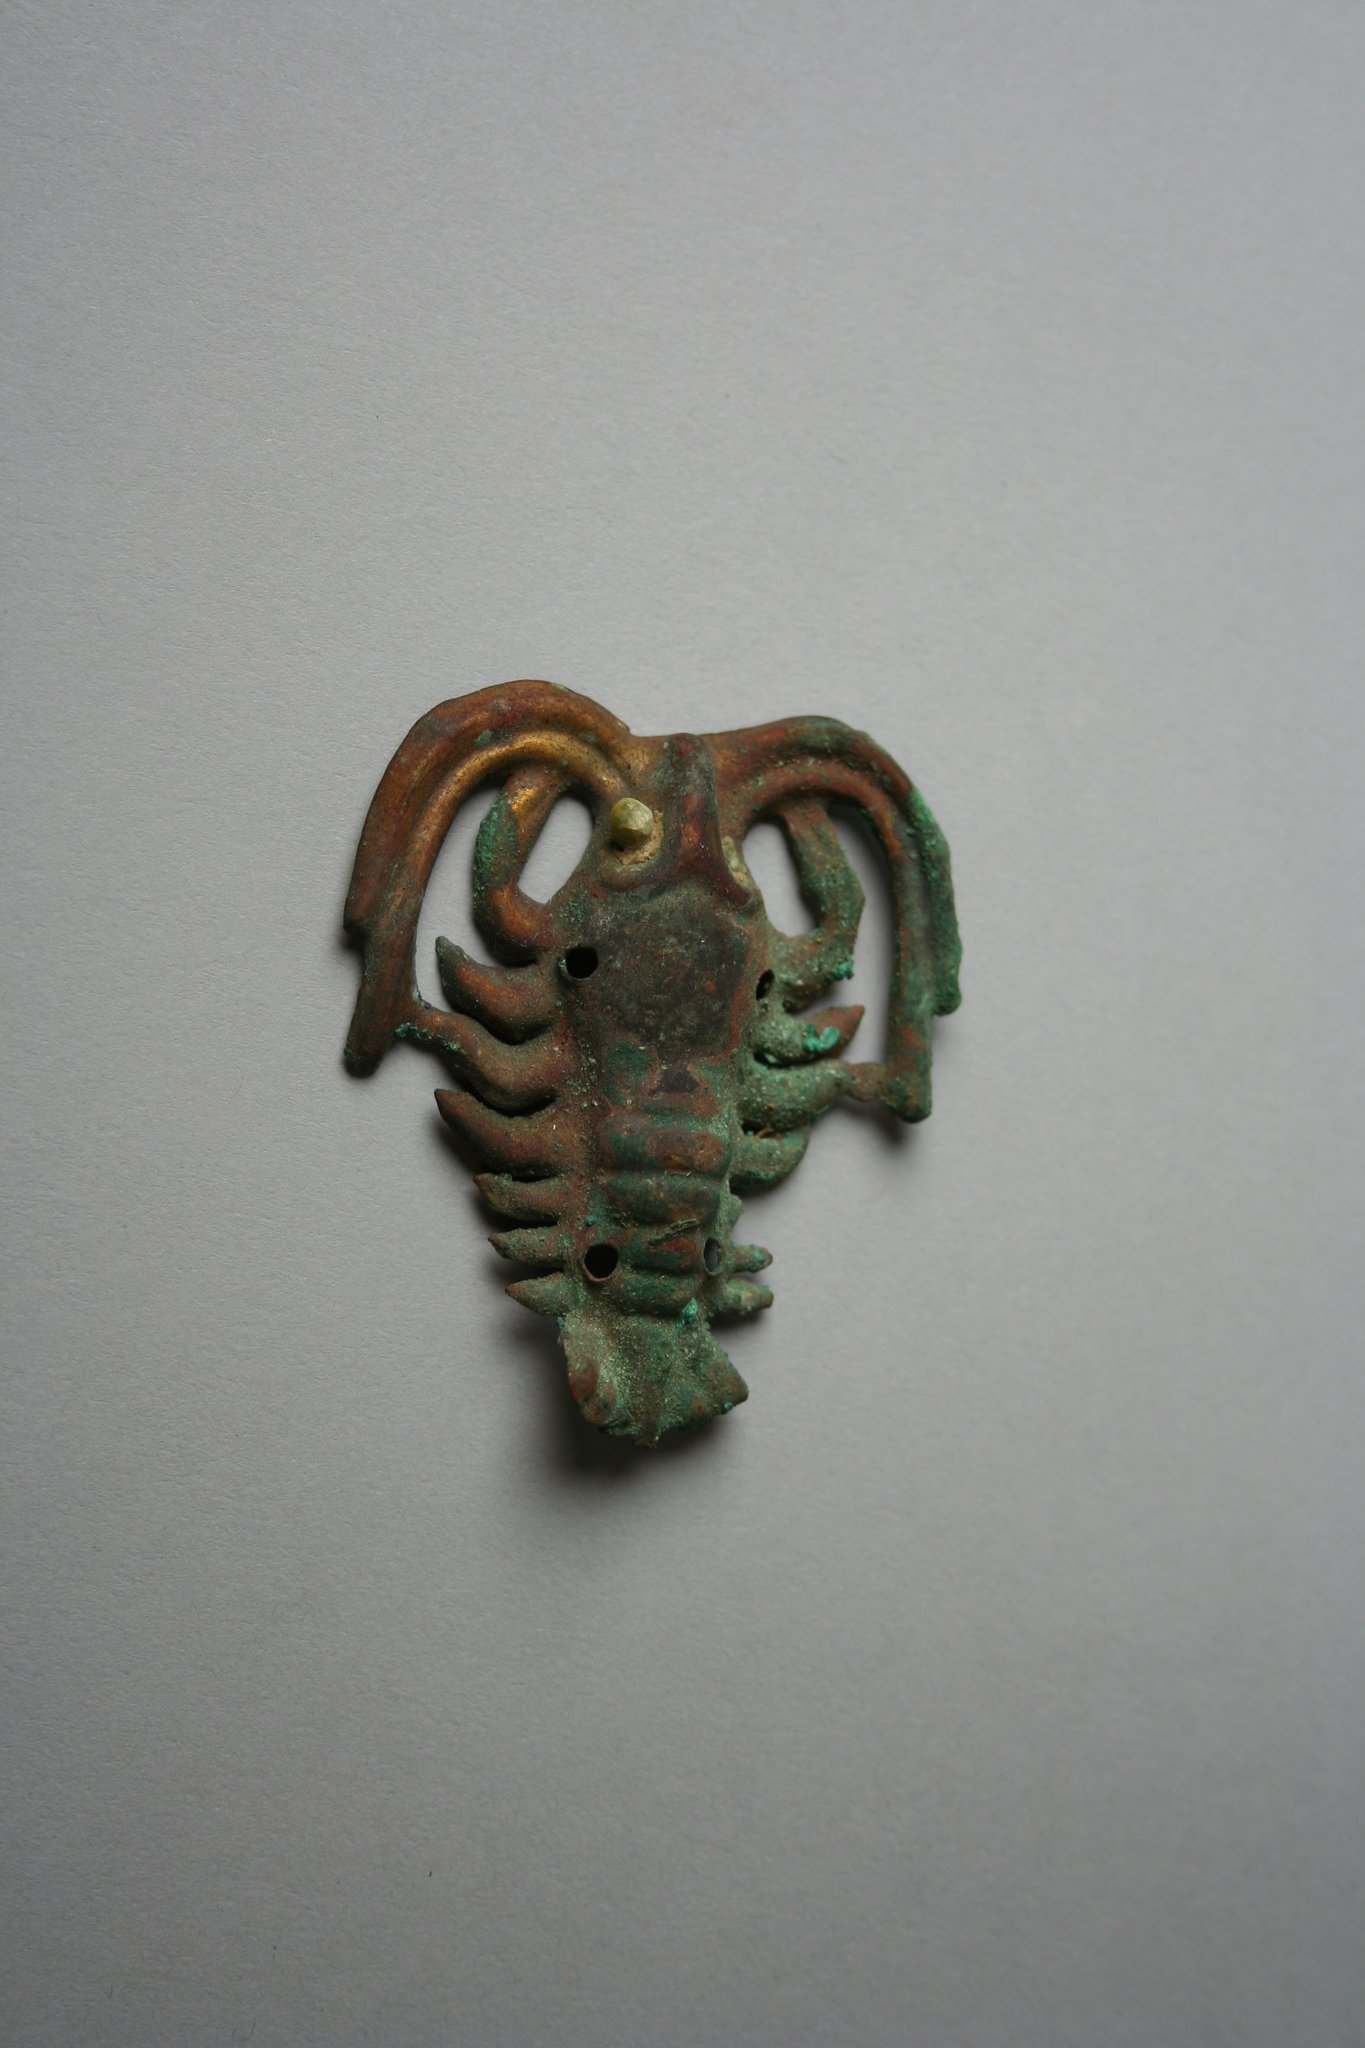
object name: ornament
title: Crayfish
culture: moche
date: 501-700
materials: gilt copper, shell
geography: peru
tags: crayfish